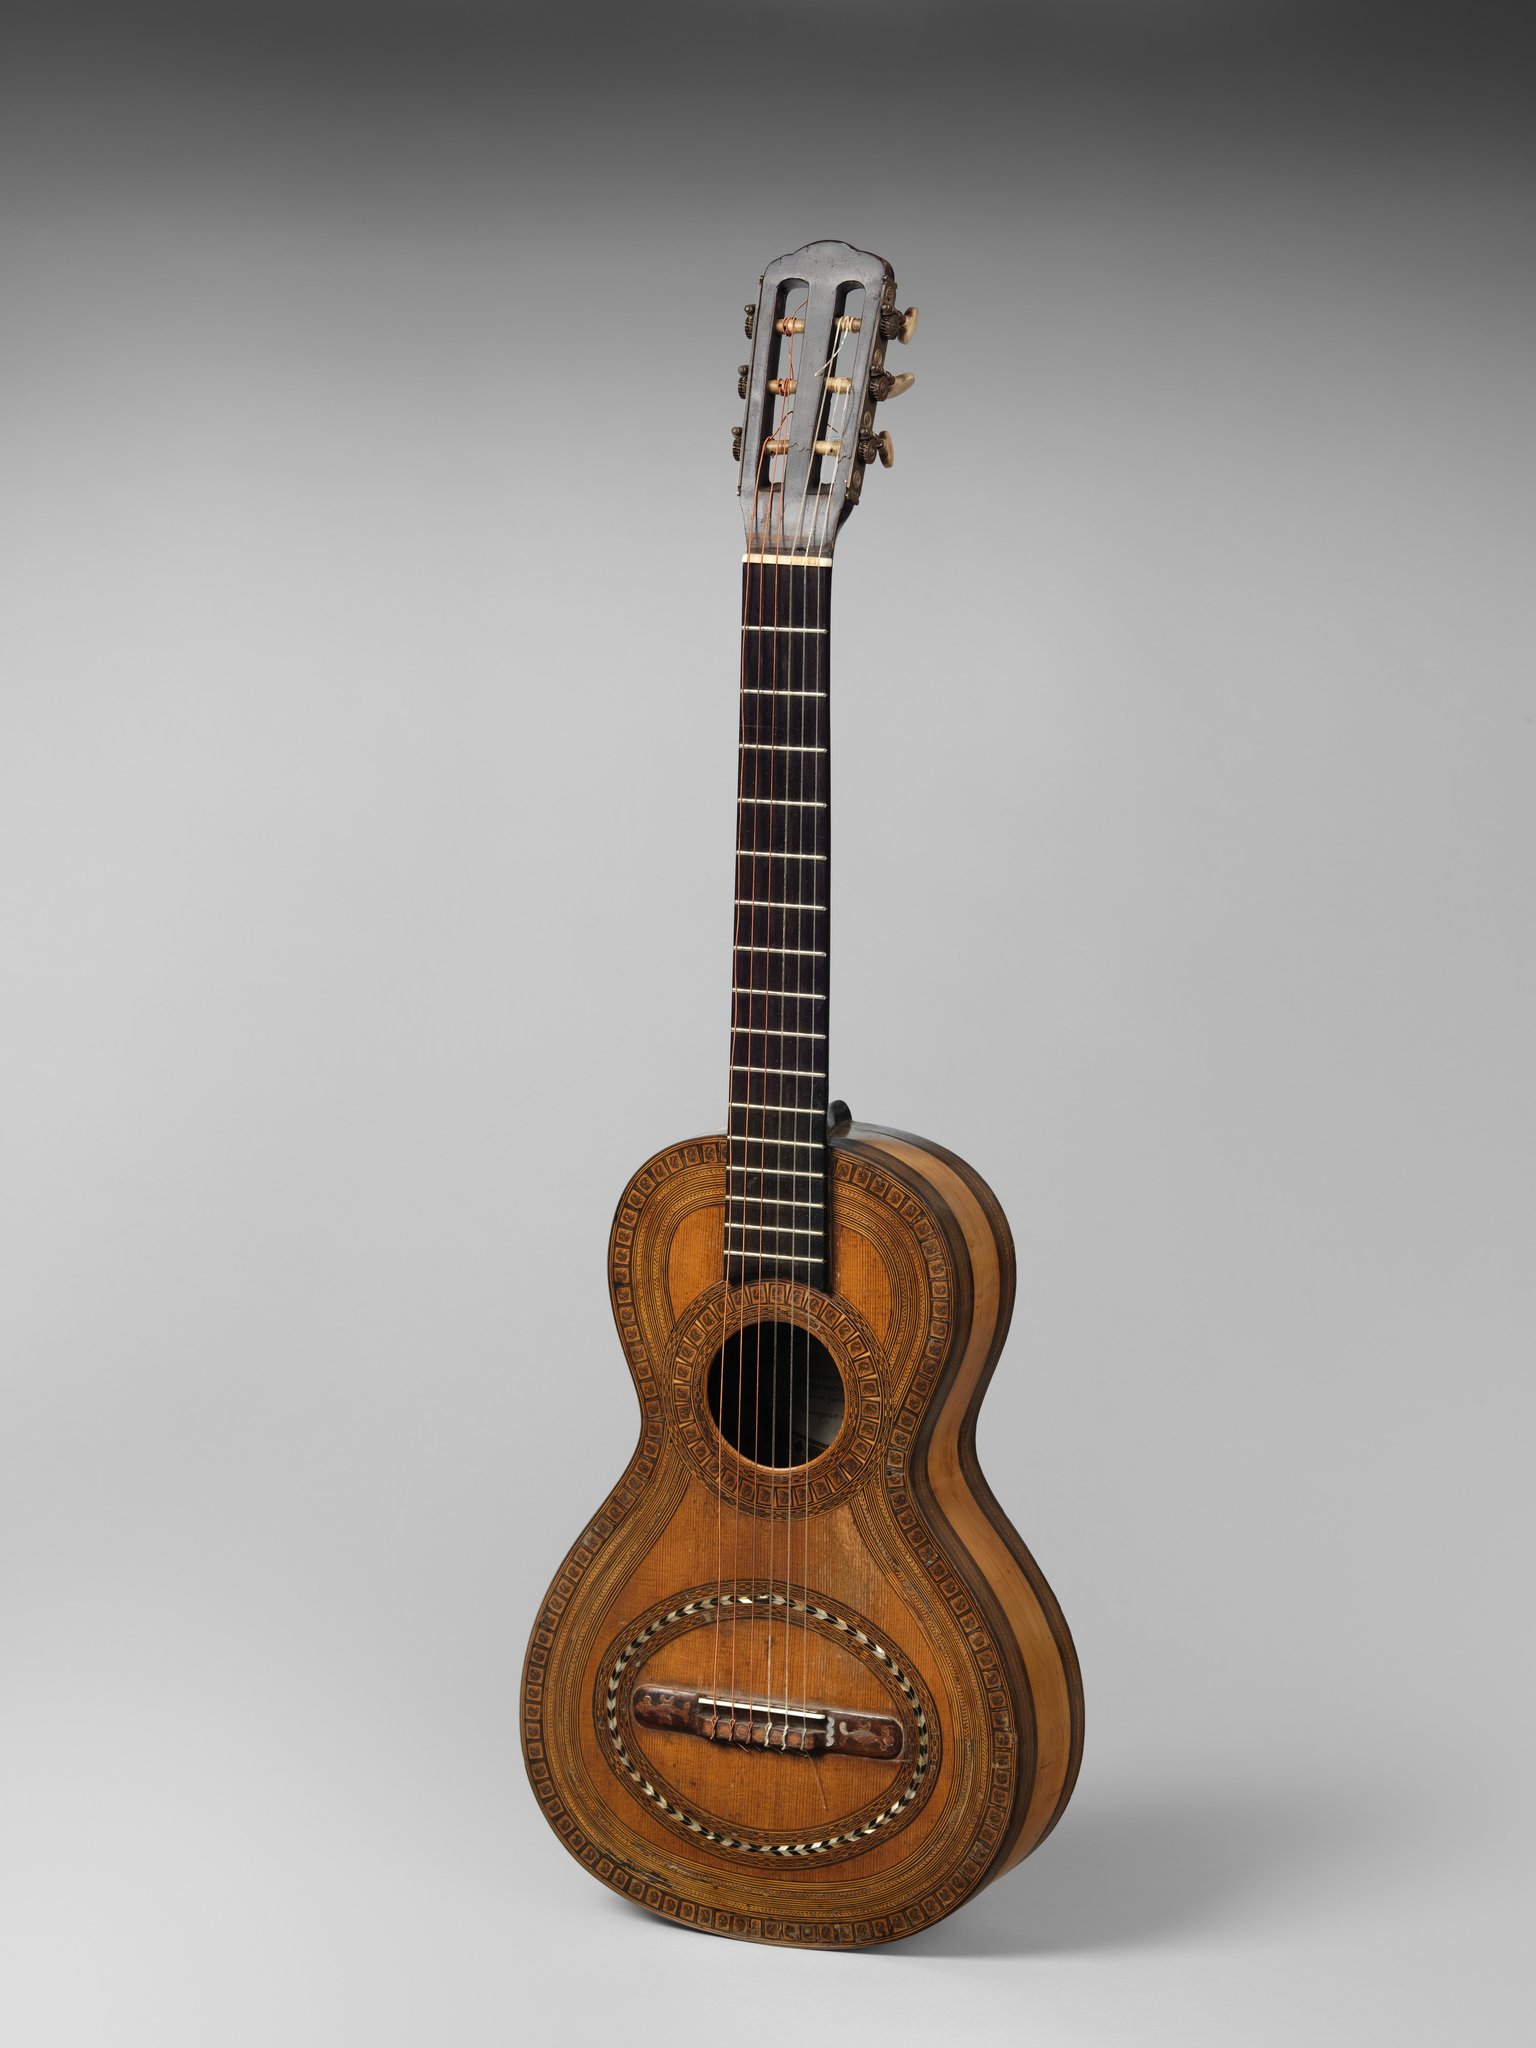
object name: guitar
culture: spanish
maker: pedro fuentes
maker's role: maker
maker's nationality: spanish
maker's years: 1860-1870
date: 1858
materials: wood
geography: spain